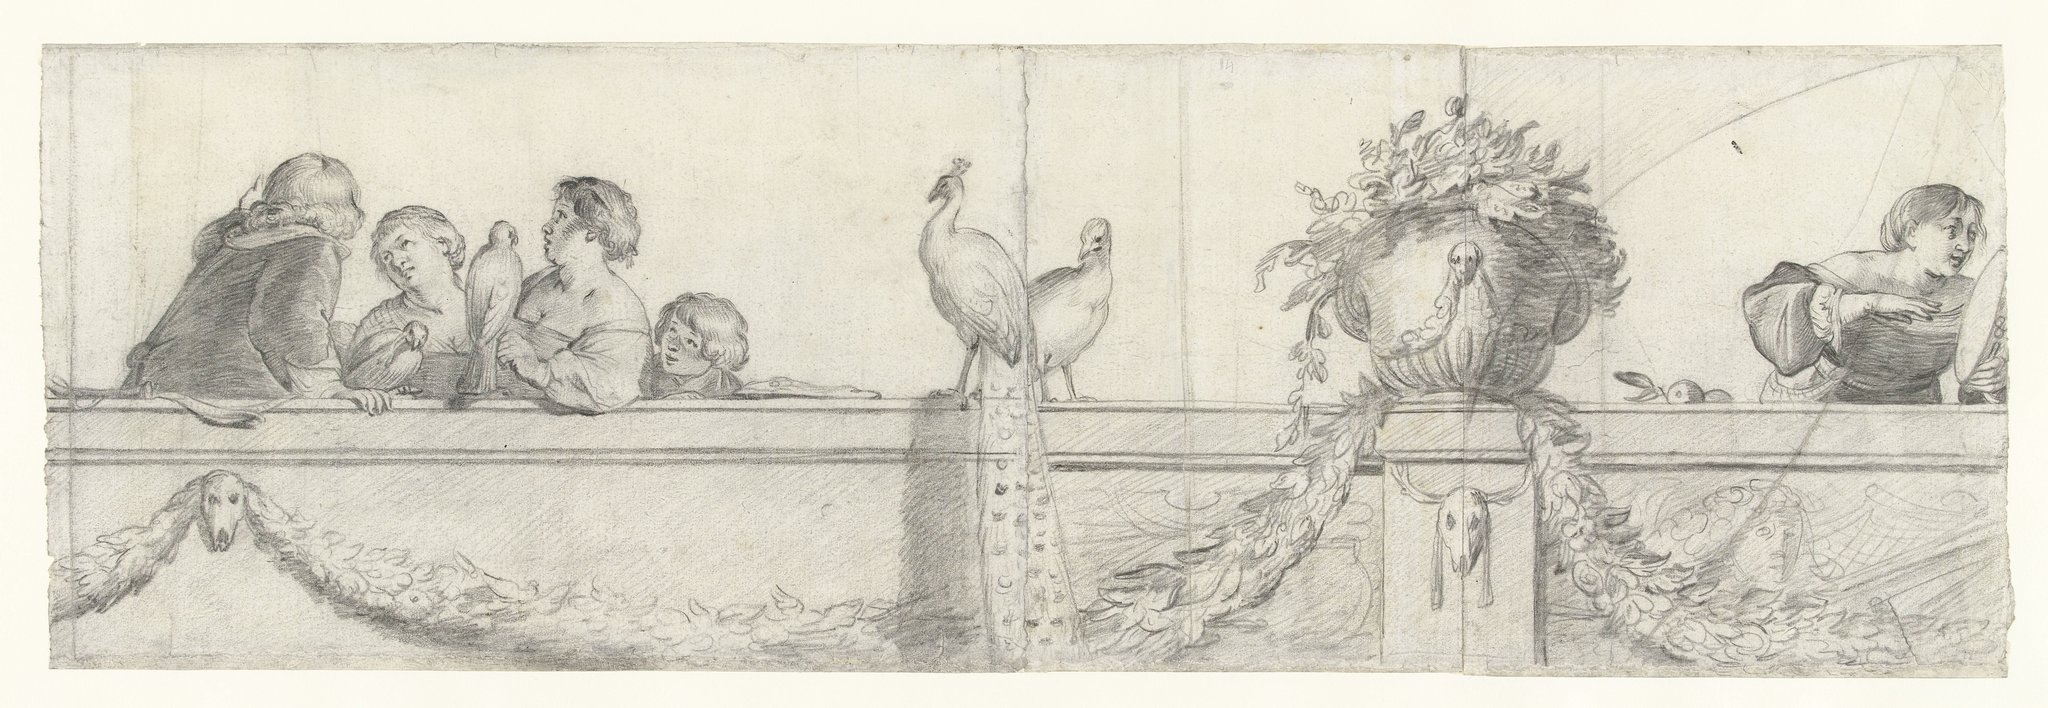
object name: drawing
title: Personen op een balustrade met festoenen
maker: cornelis holsteyn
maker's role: draughtsman, painter, print maker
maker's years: 1618-1658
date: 1633-1638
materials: chalk, paper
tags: ornamental birds: parrot, ornamental birds: peacock, balustrade